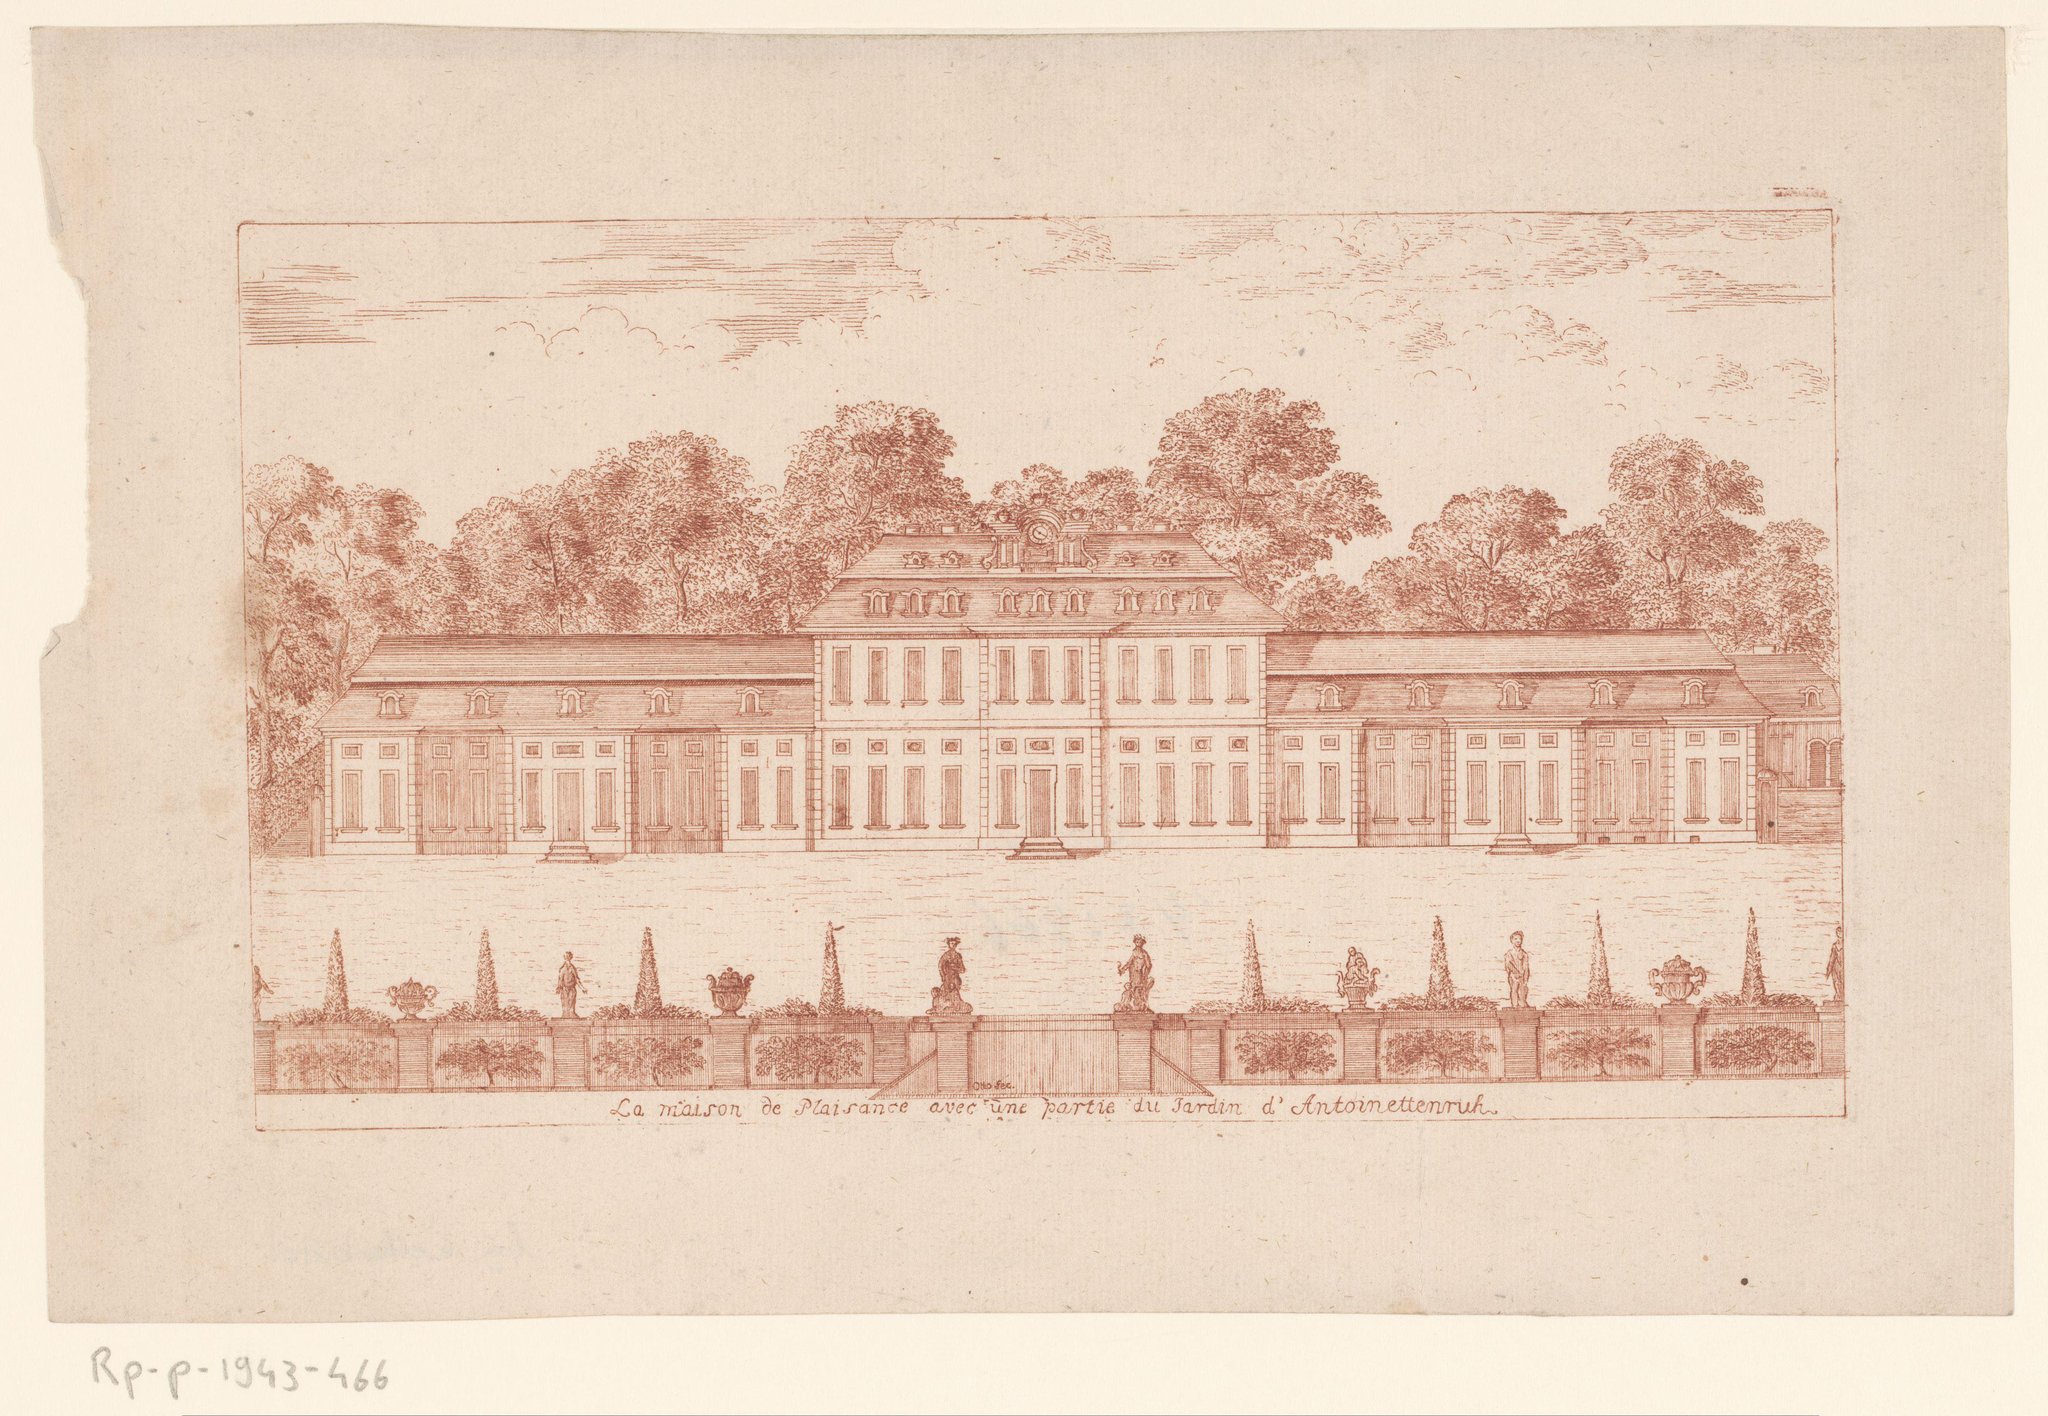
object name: print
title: Gezicht op Schloss Antoinettenruh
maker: otto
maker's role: print maker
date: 1800-1899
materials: paper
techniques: etching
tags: palace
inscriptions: collector's mark: Lugt 2228